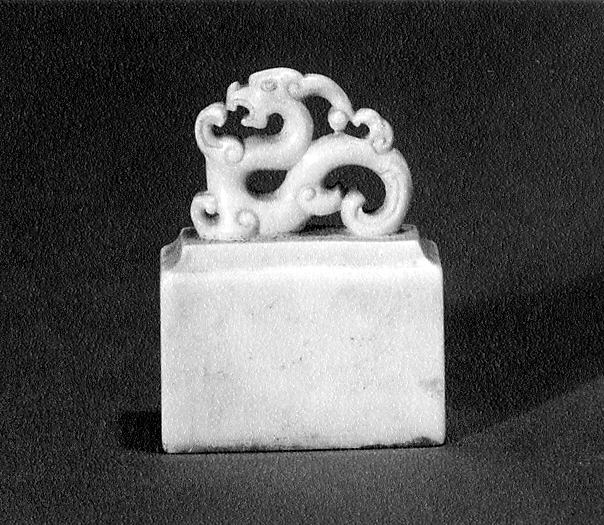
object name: seal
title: Seal with the Legend "Zhi xi wo gui"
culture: chinese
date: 1701-1800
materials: ivory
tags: dragons